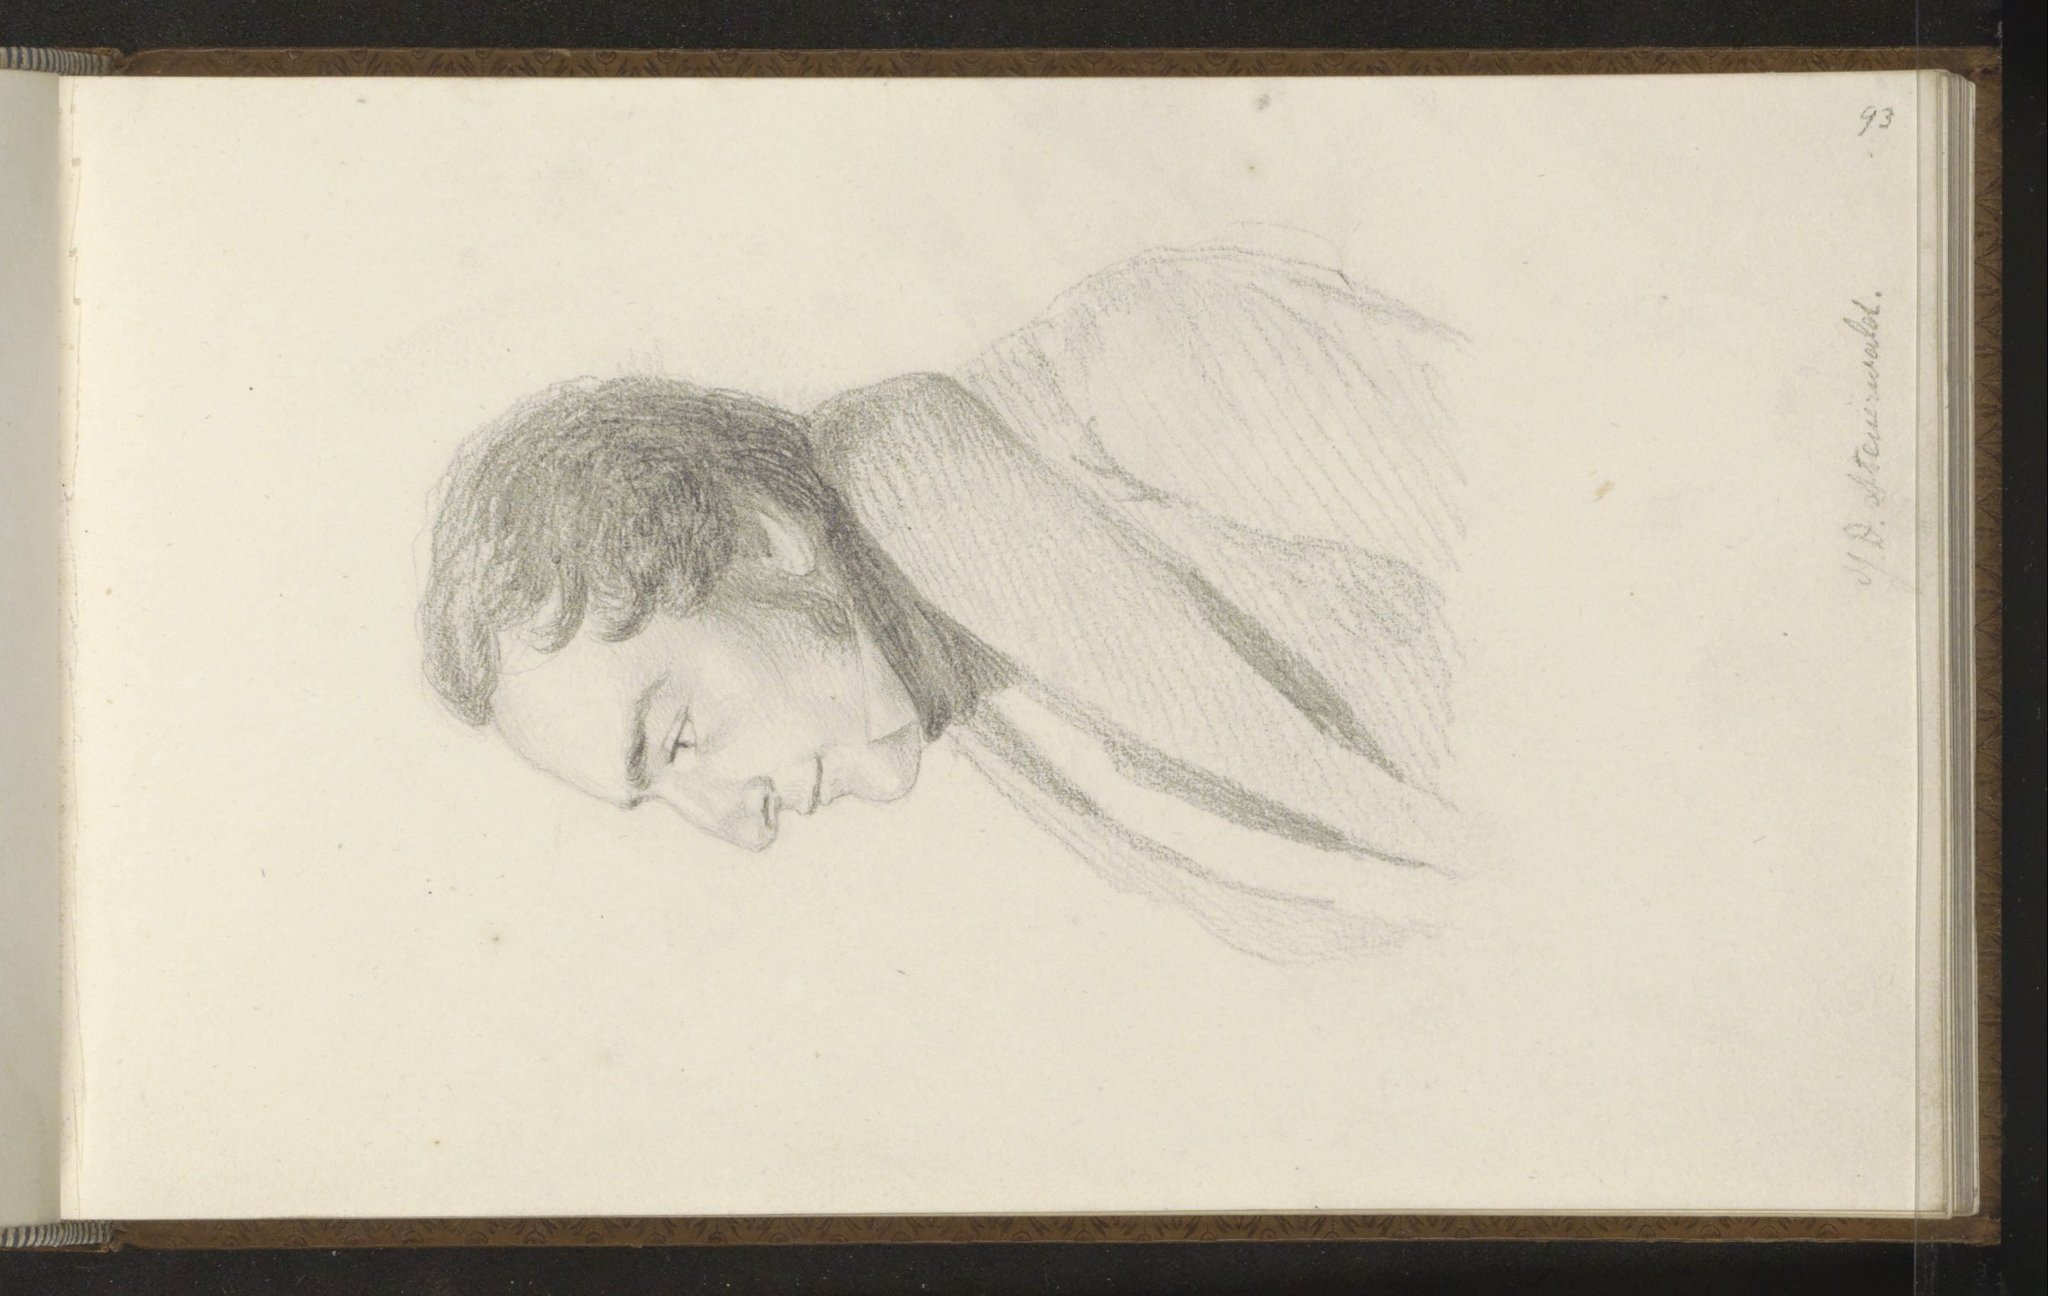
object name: sketchbook leaf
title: Portret van Jan Dam Steuerwald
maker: christian heinrich gottlieb steuerwald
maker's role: draughtsman, print maker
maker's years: 1802-1874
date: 1834-1844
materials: paper, pencil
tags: bergen op zoom, the hague, print maker, printer, jan dam steuerwald, historical persons (portraits and scenes from the life)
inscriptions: annotation: ‘J.D. Steuerwald’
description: Bladzijde 93 uit een schetsboek met 188 bladzijden.